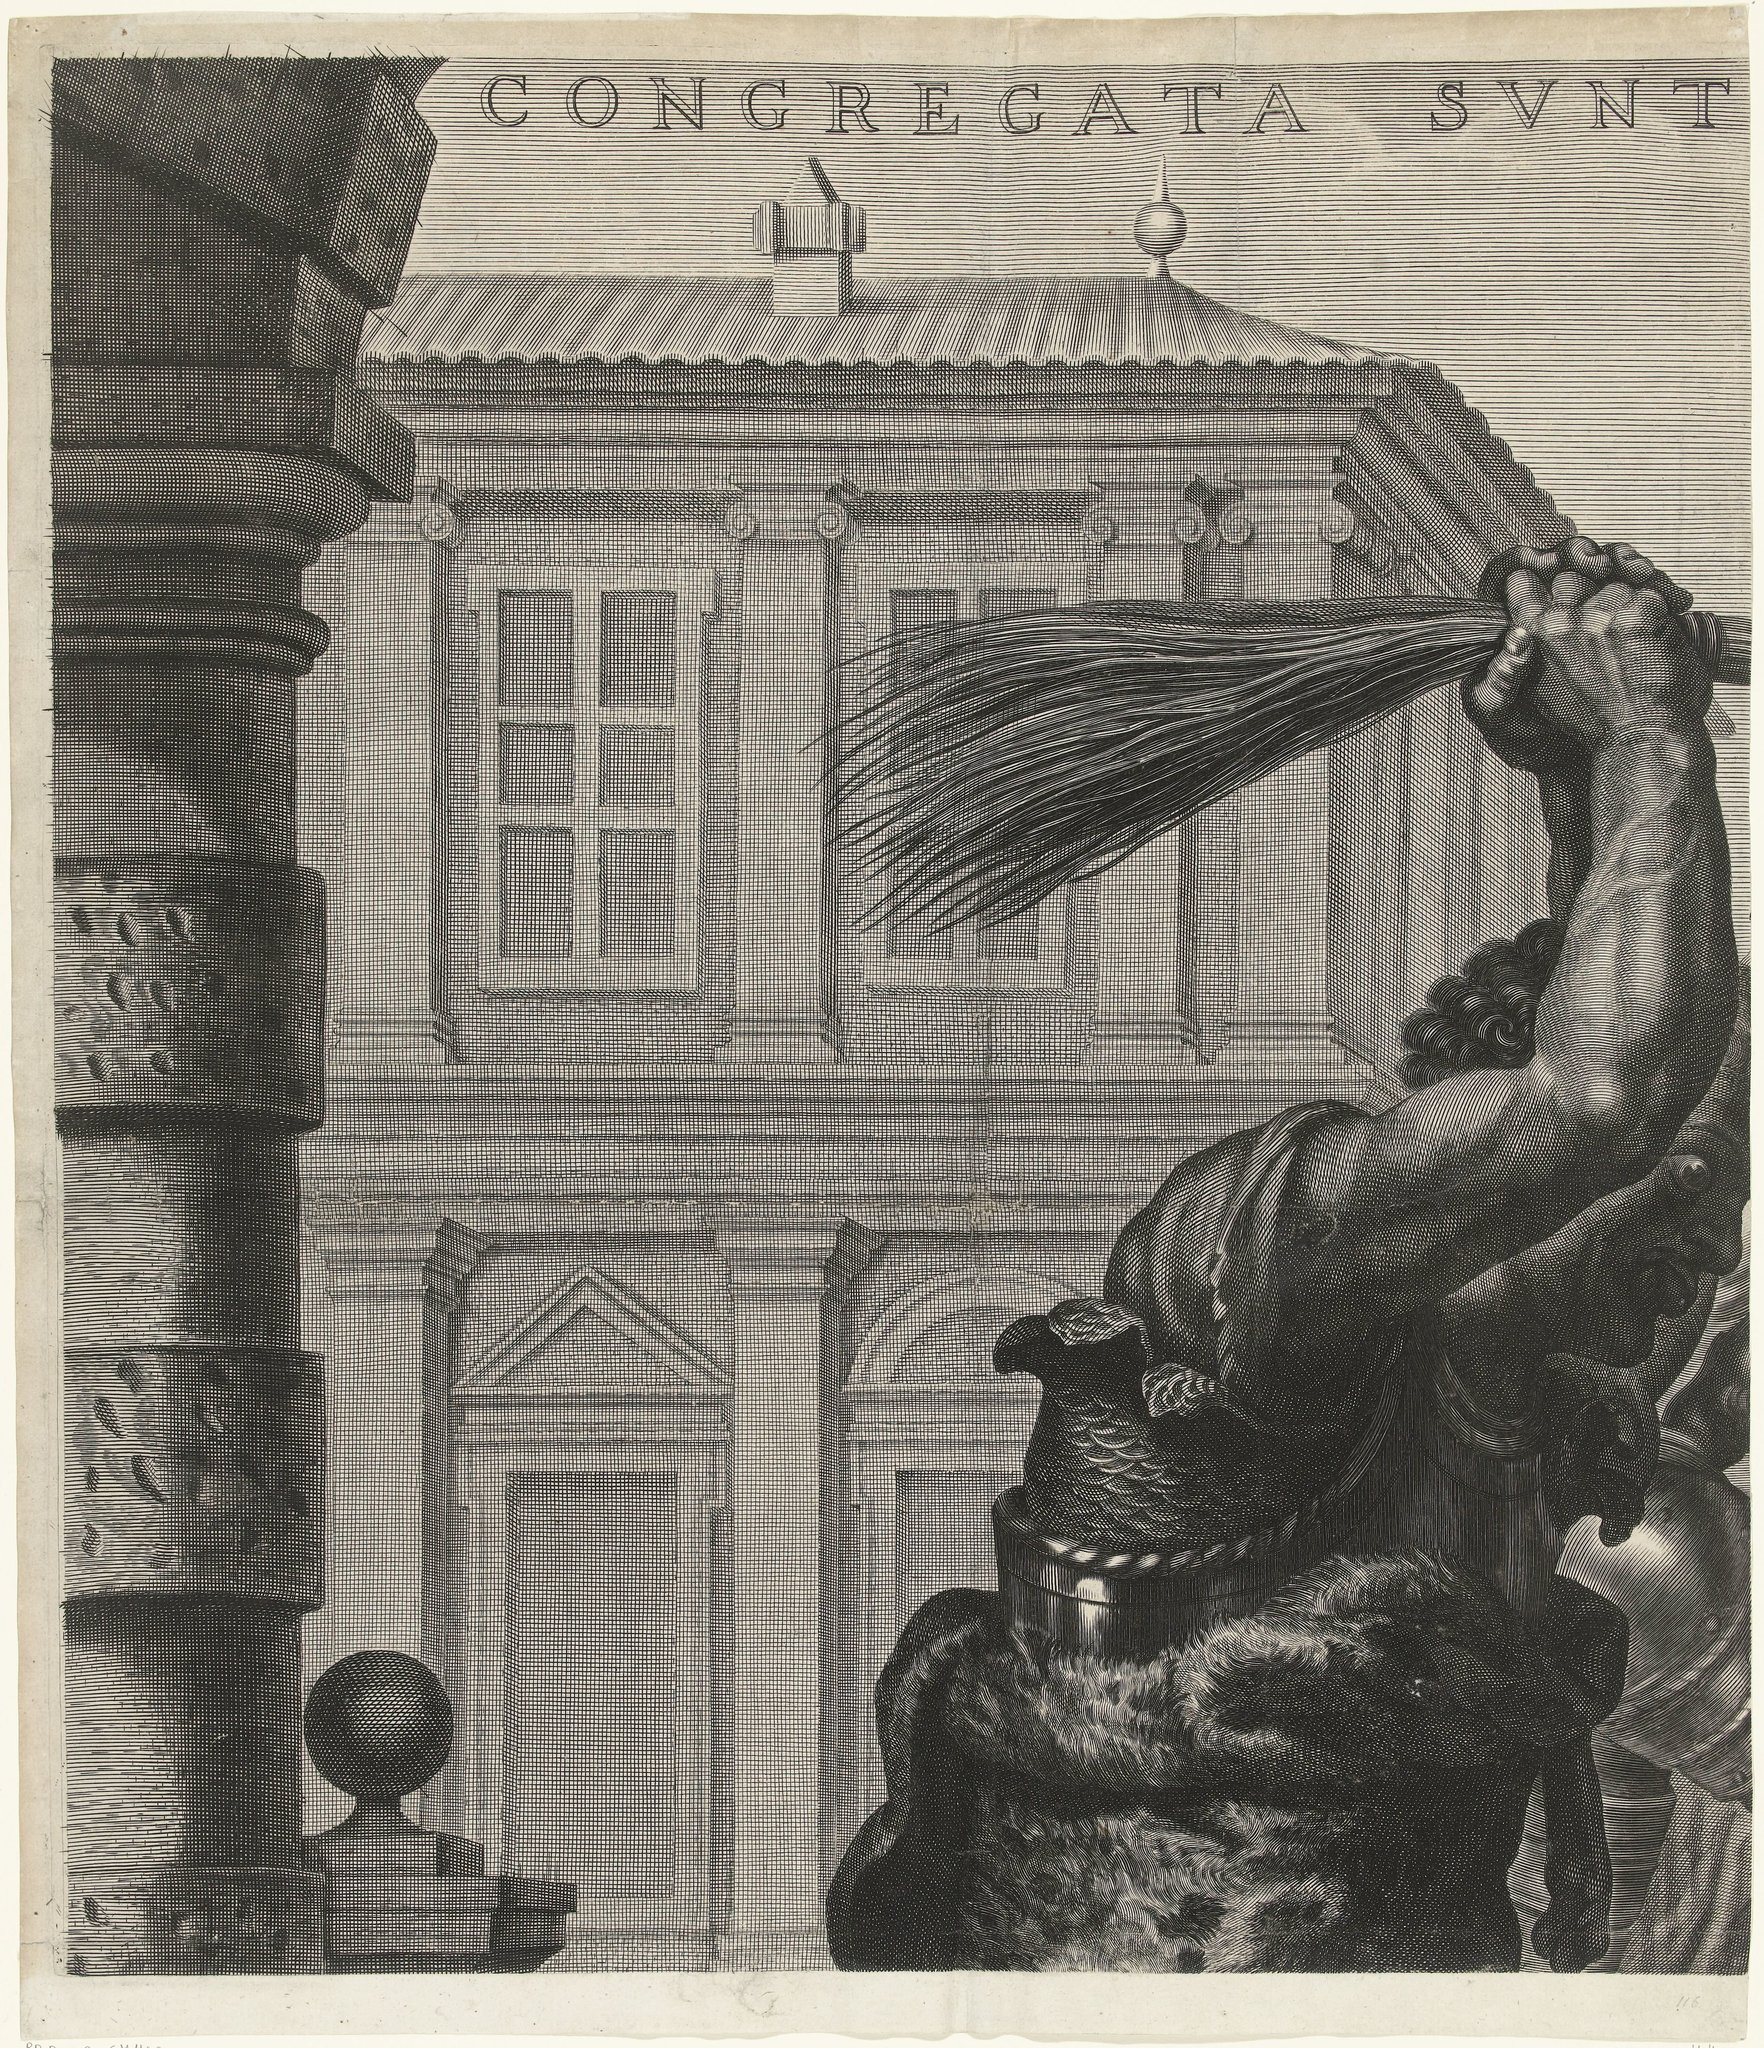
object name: print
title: Geseling van Christus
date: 1625-1670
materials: paper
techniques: engraving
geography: antwerp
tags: flagellation by soldiers, christ usually tied to a column (matthew 27:26; mark 15:15; john 19:1)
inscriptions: collector's mark: Lugt 240 of 1838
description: In het midden van de prent staat Christus. Hij wordt door twee mannen gegeseld. Een man heeft een roede vast, de ander een zweep met knopen. Twee andere mannen houden Christus in bedwang. Rechts van de prent kijkt Pilatus toe. Op de achtergrond de Farizeeën en schriftgeleerden, die van op afstand de marteling volgen. De prent heeft een Latijns bovenschrift met een citaat uit Psalm 34 (34:15) en een Latijns onderschrift met een citaat uit het evangelie van Johannes (Johannes 19:5).